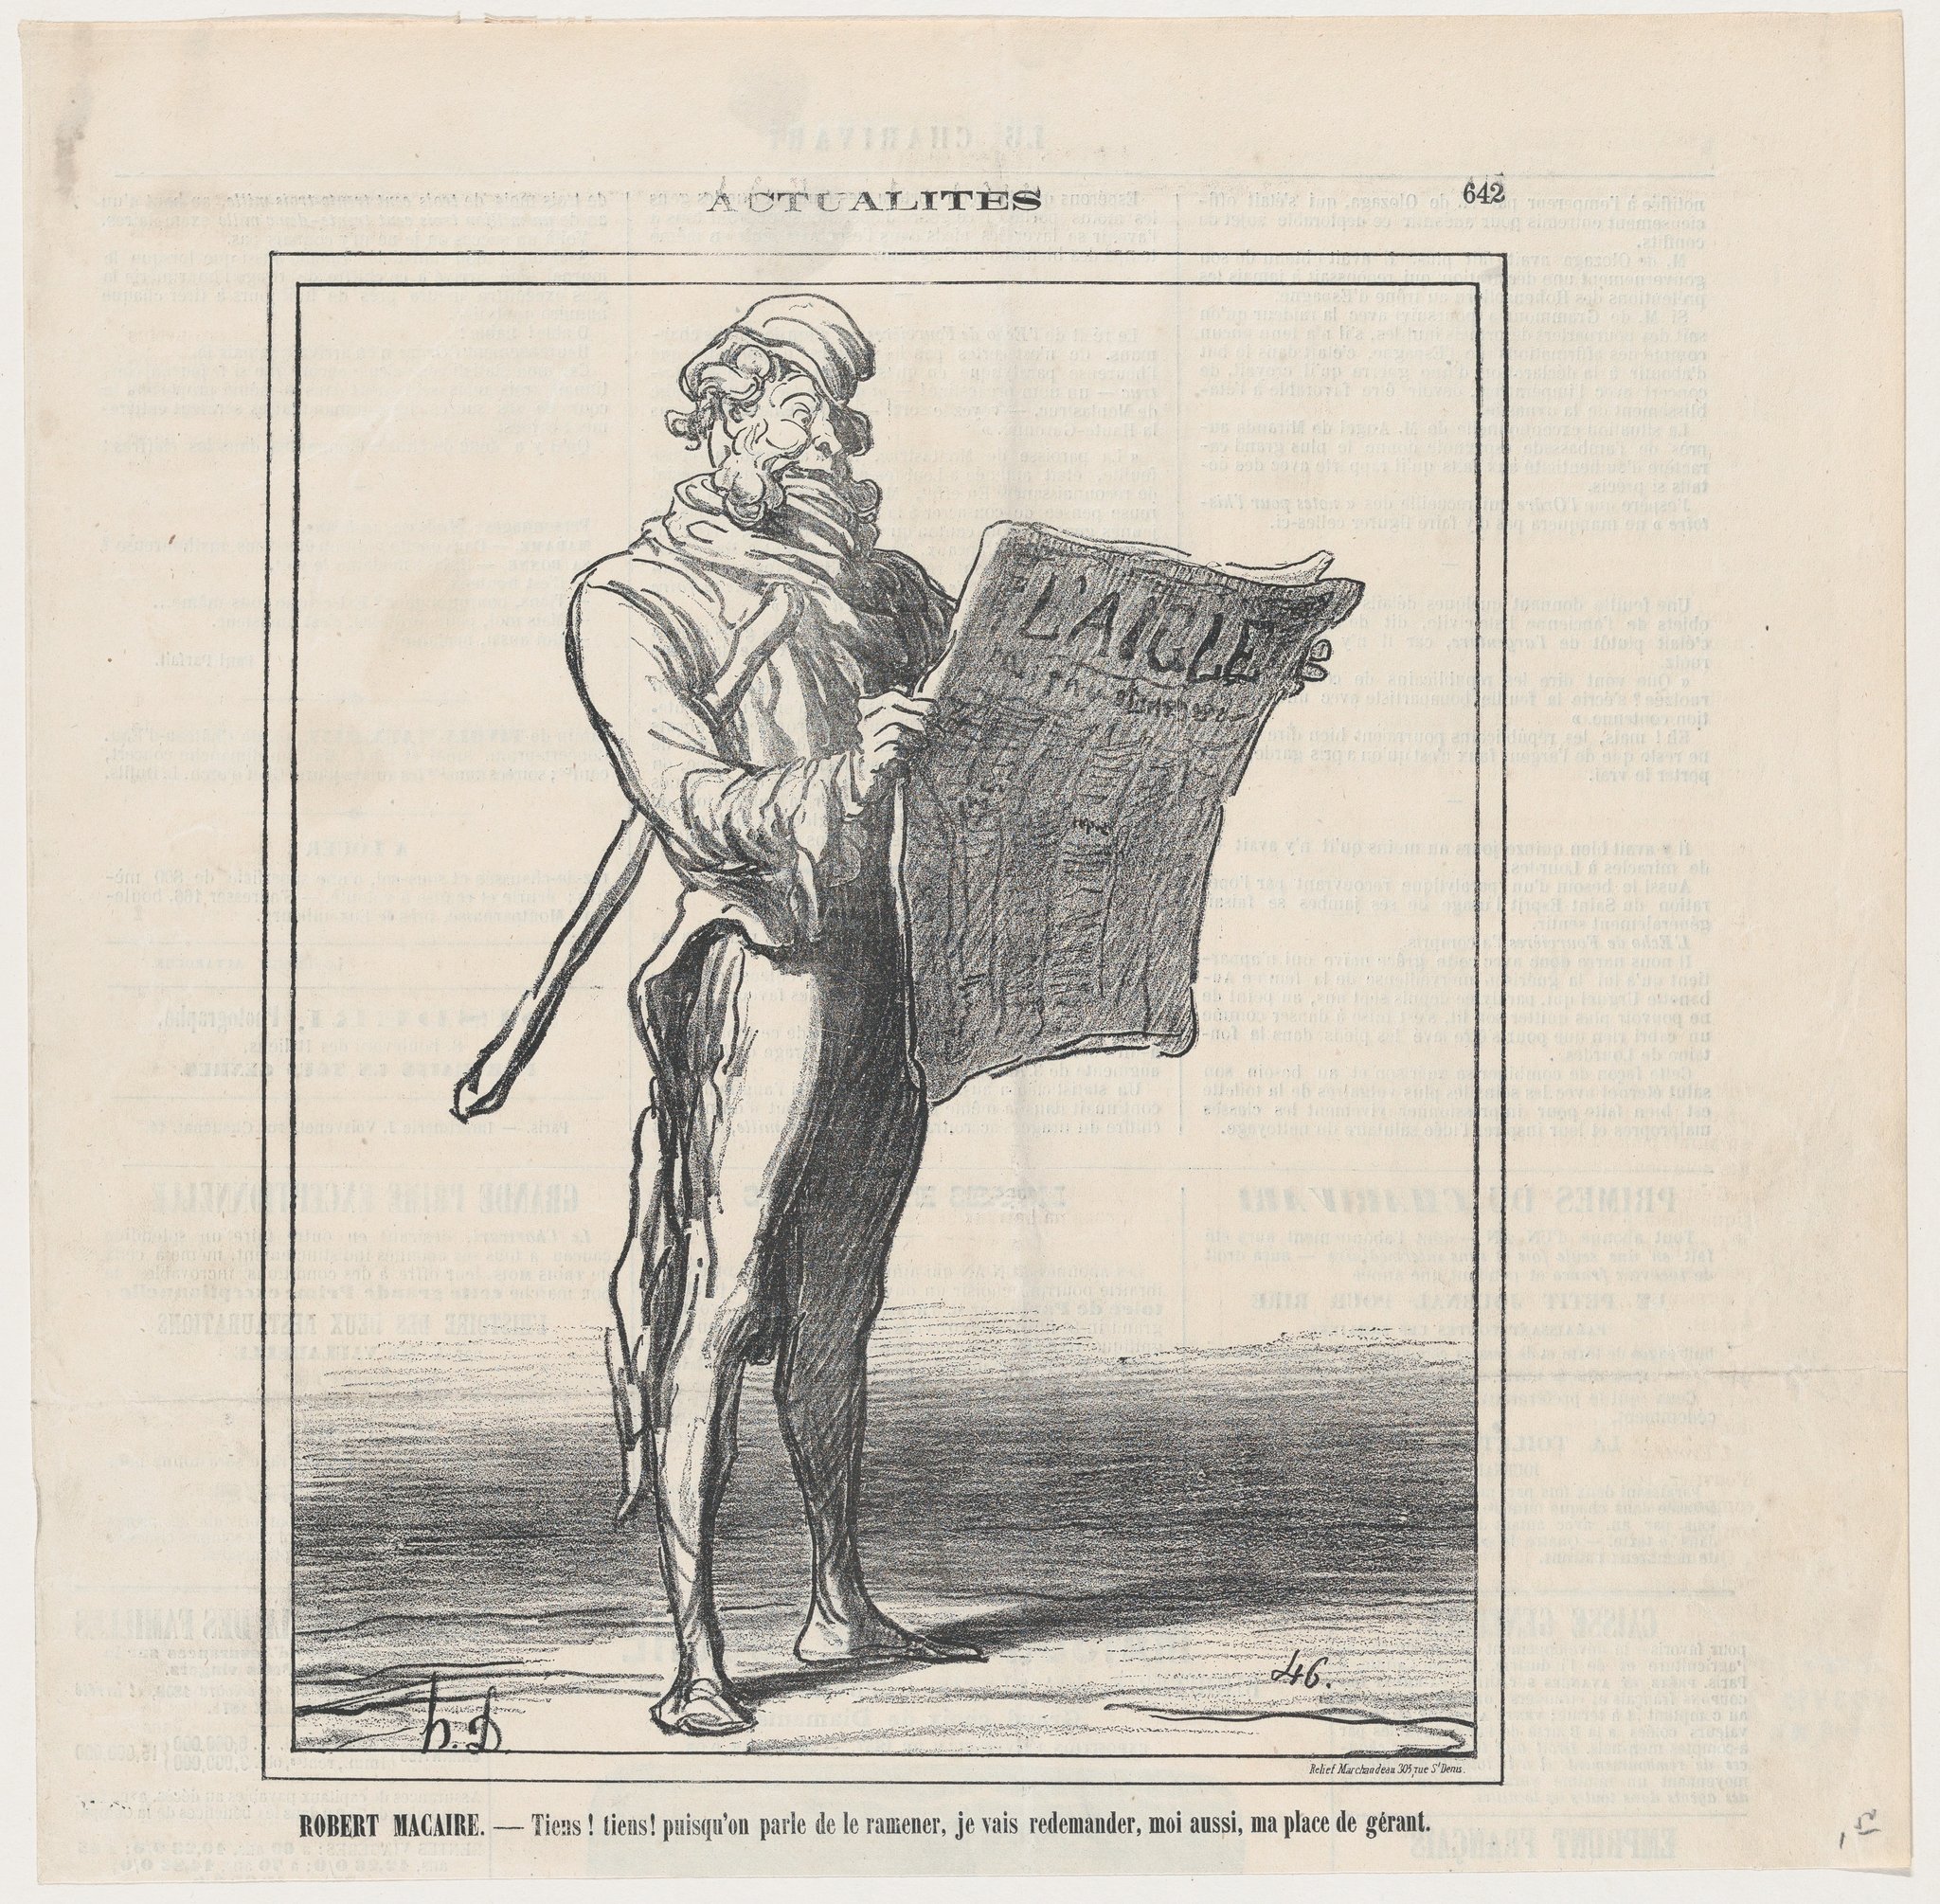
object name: print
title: Robert Macaire: Well, well, it seems he's allowed to return! Maybe I should apply for my old position as manager, from "News of the day"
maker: honoré daumier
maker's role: artist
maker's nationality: french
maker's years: 1808-1879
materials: paper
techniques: lithograph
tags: men,reading